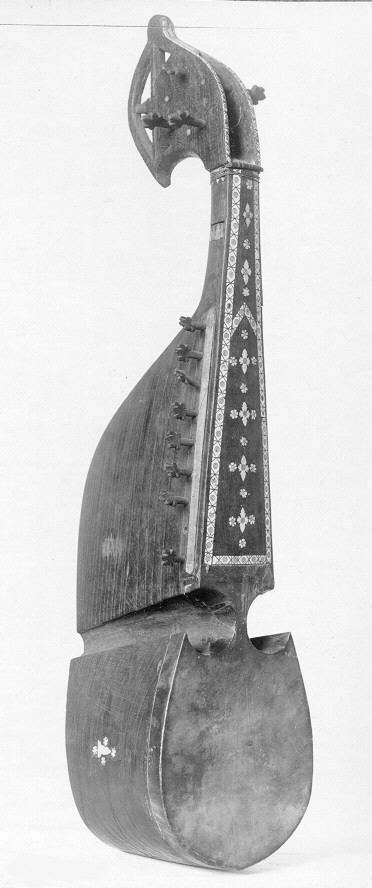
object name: sarod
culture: indian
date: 1867-1900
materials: ivory, skin, wood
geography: india